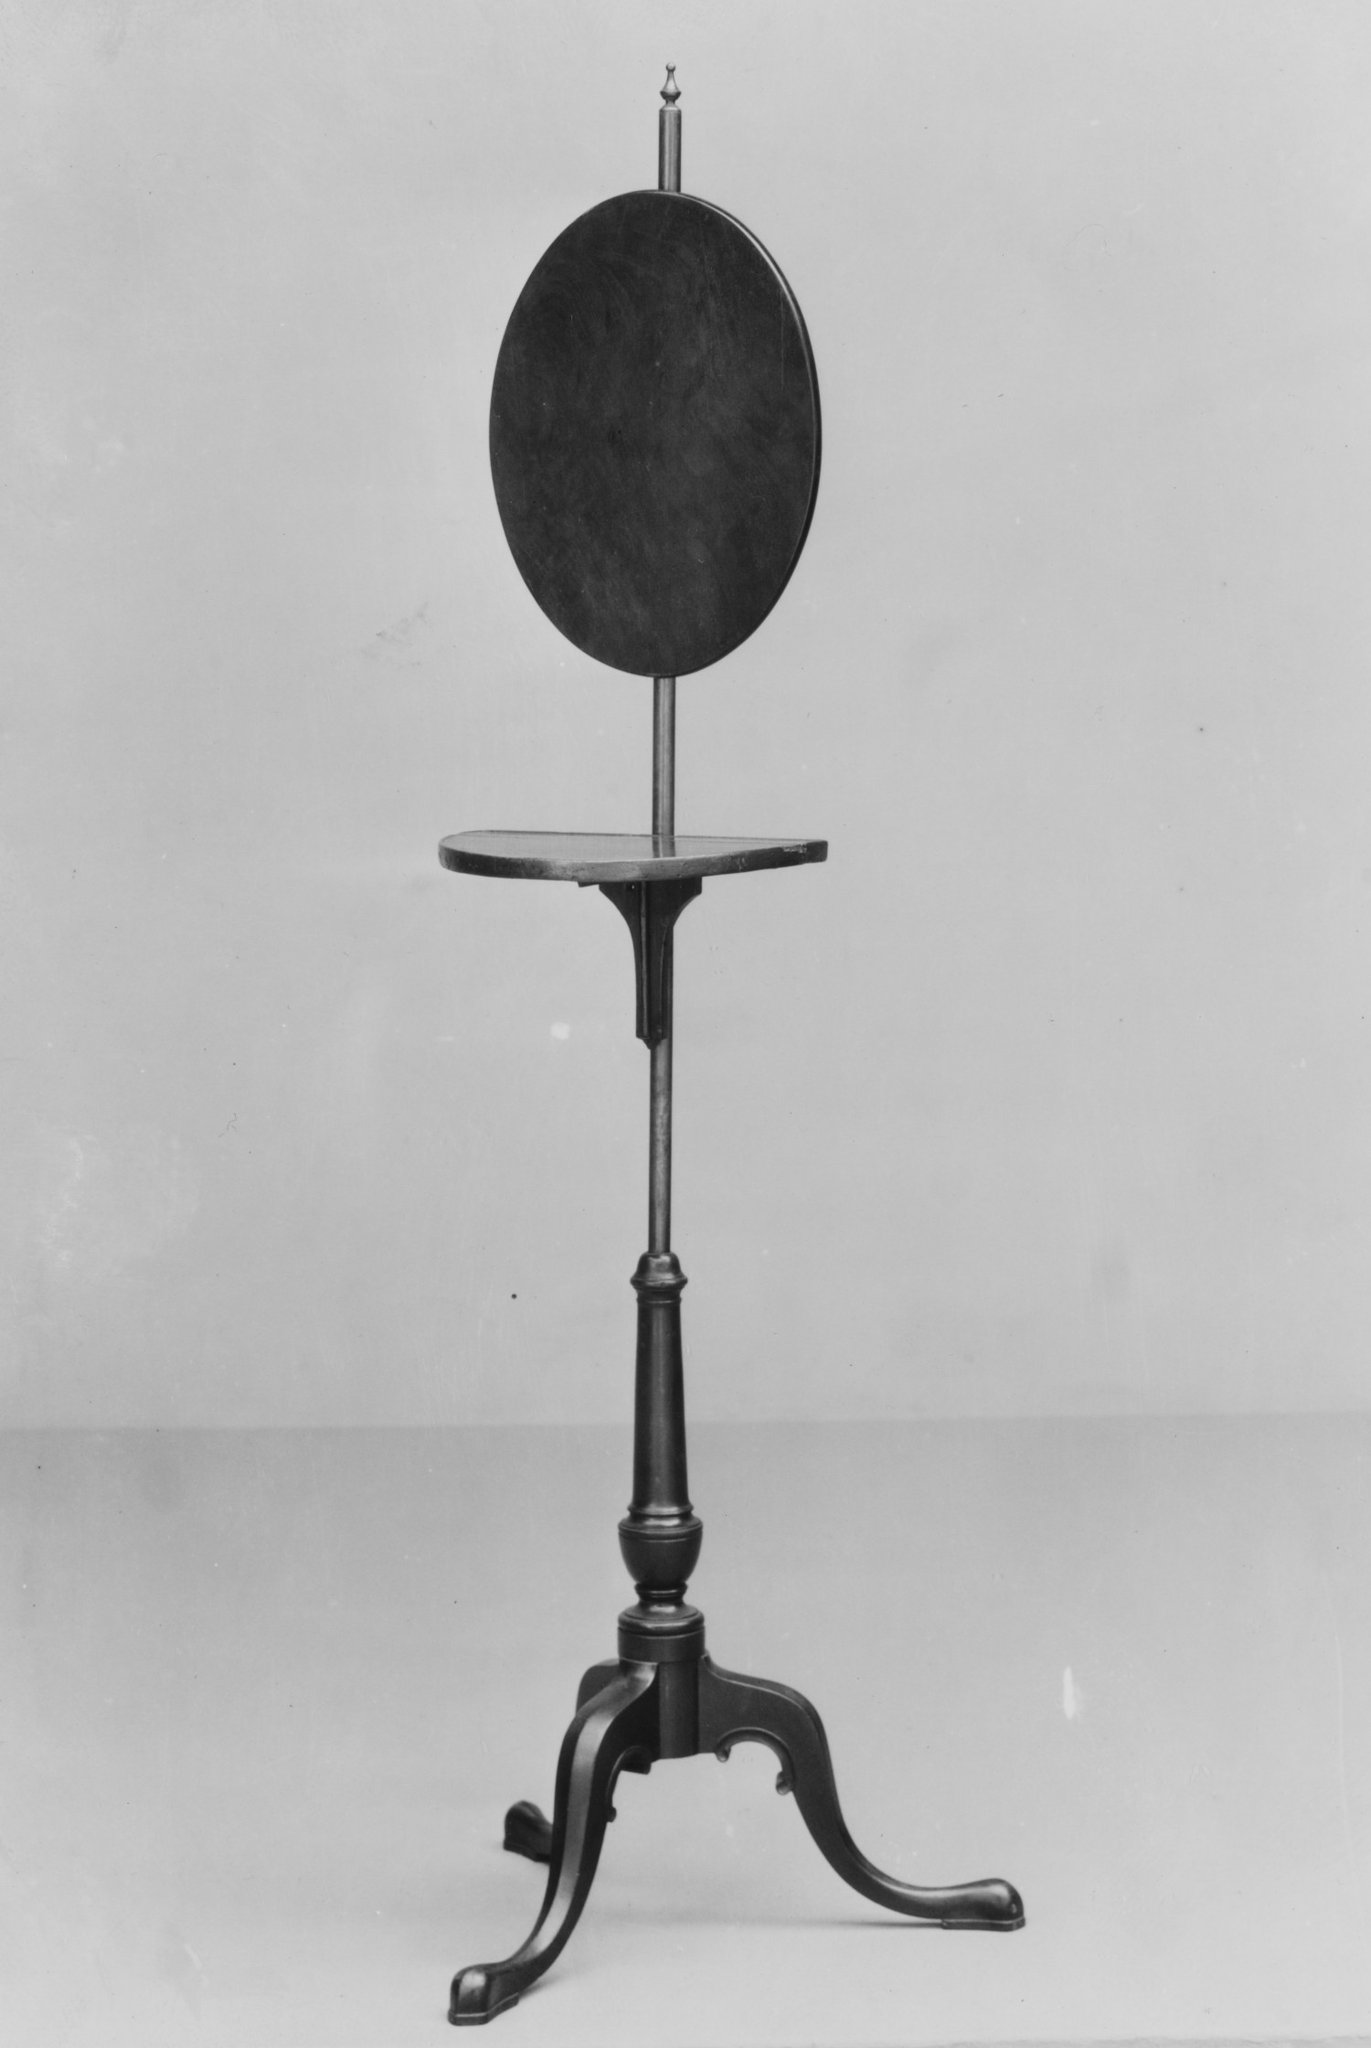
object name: firescreen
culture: american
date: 1775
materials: wood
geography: united states